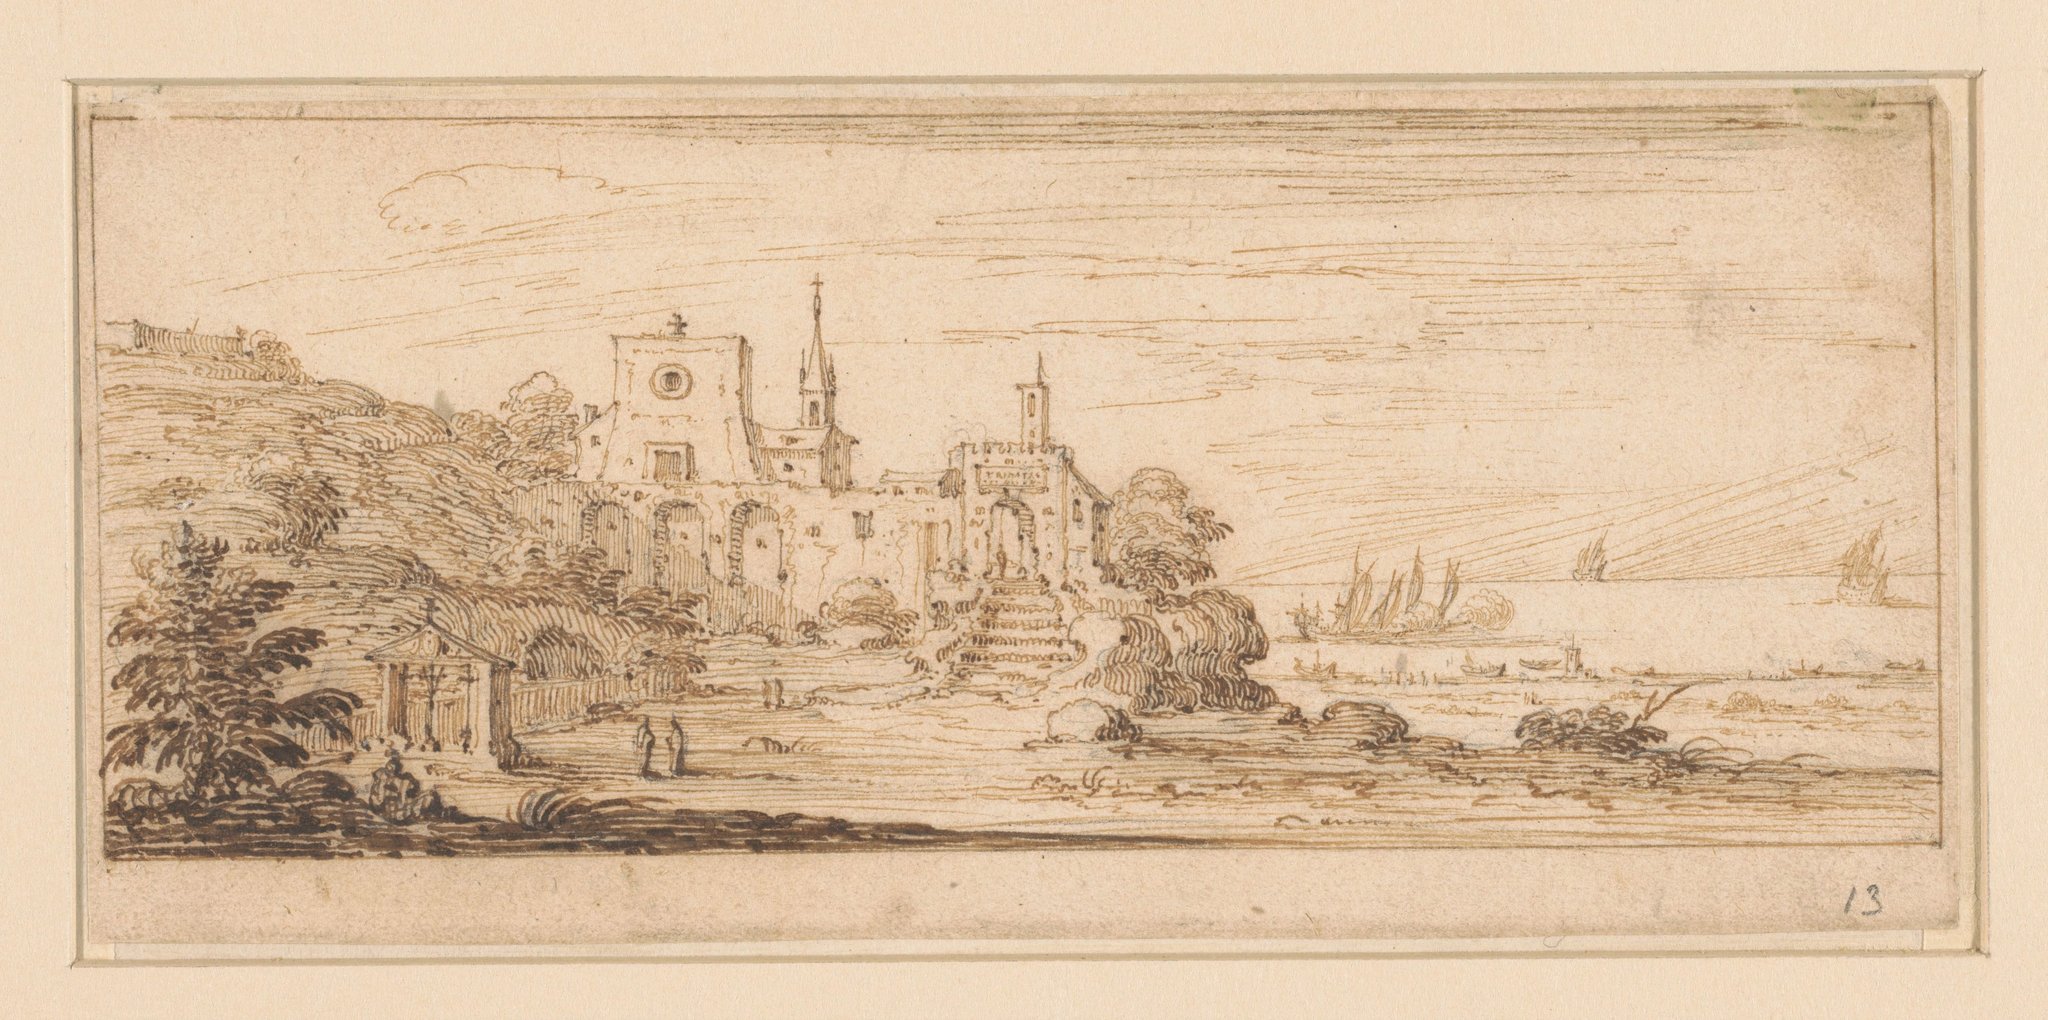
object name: design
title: Kustgezicht met kerk van de Heilige Drie-eenheid van Gaeta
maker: israël silvestre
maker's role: draughtsman, print maker, publisher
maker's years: 1621-1691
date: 1636-1687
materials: ink, paper, pencil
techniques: pen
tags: abbey, monastery, convent ~ roman catholic church, coast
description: Kustgezicht met een klooster met hoge muren, rechts een zee met schepen. Ontwerp voor een prent van François Collignon, uit een serie van vier landschapen met Italiaanse uitzichten.